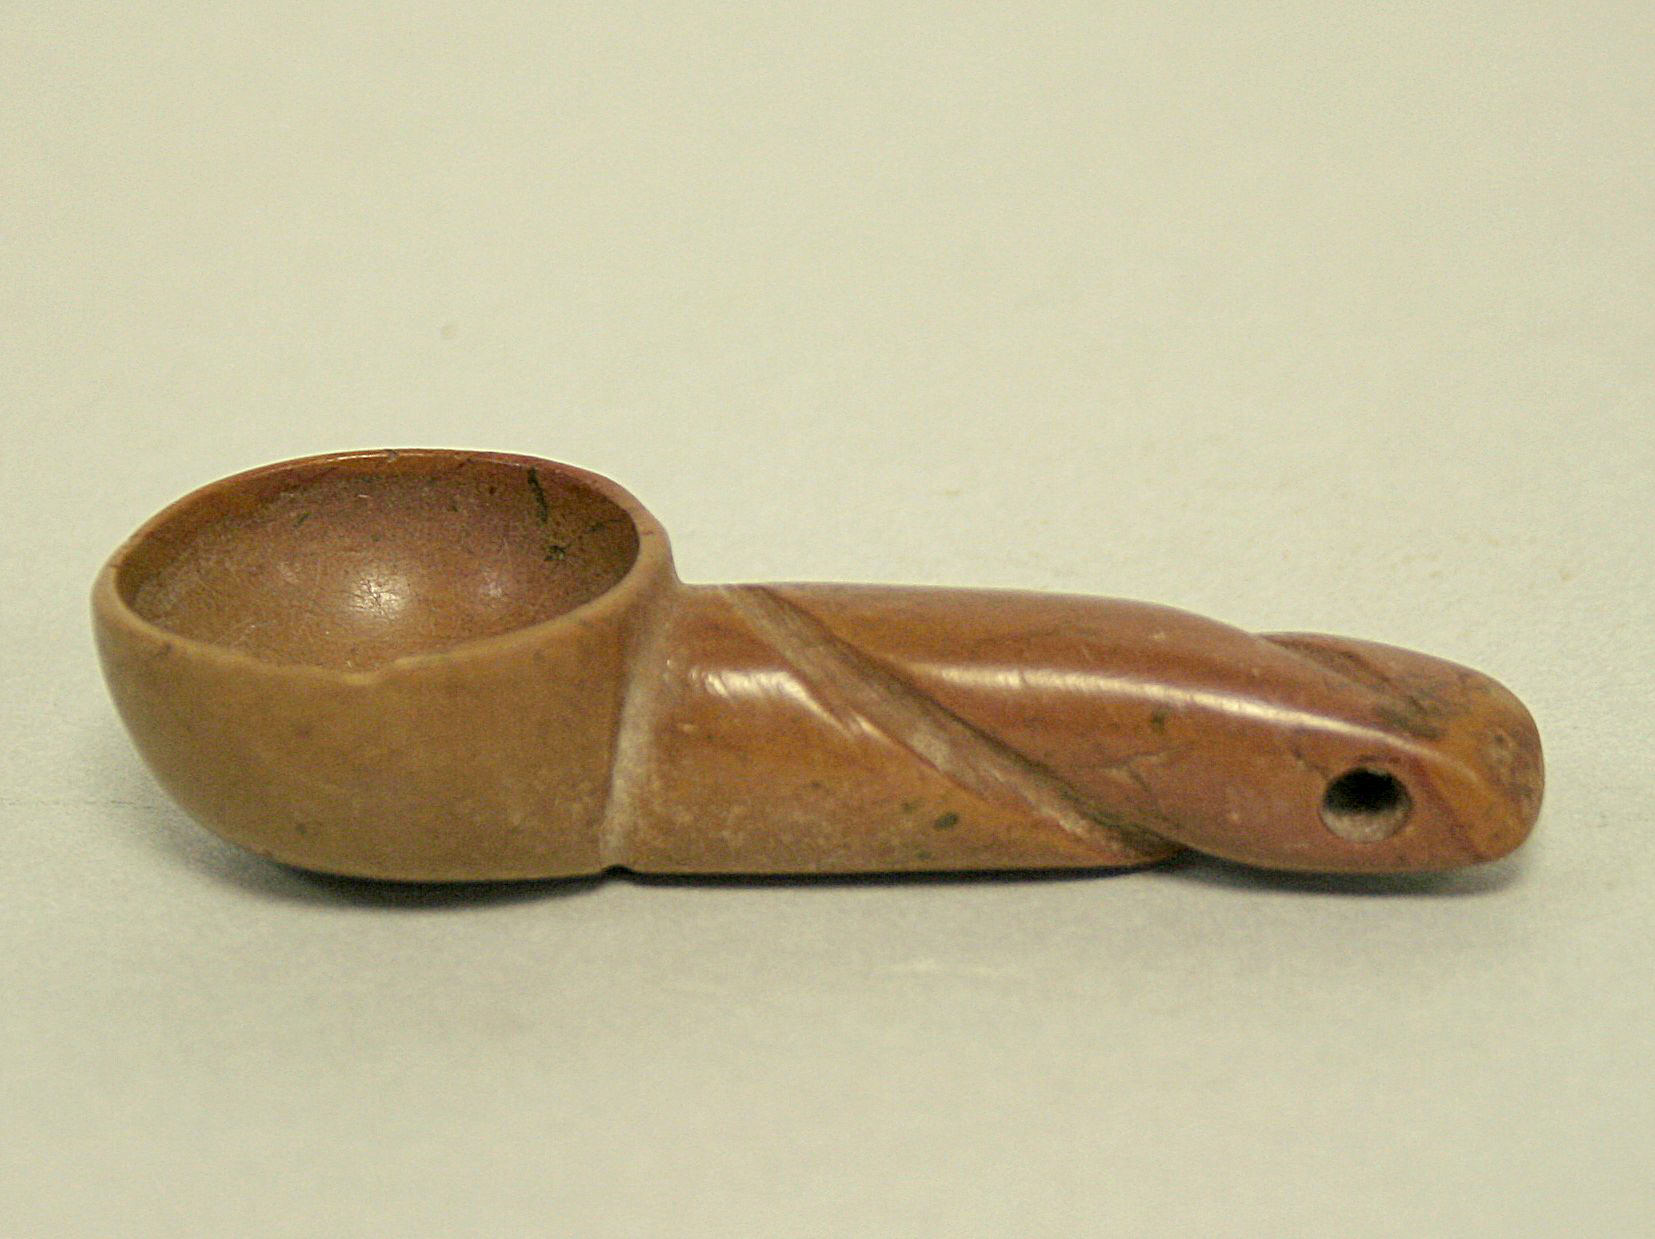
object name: spoon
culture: chavin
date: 700-101 BCE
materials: stone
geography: peru